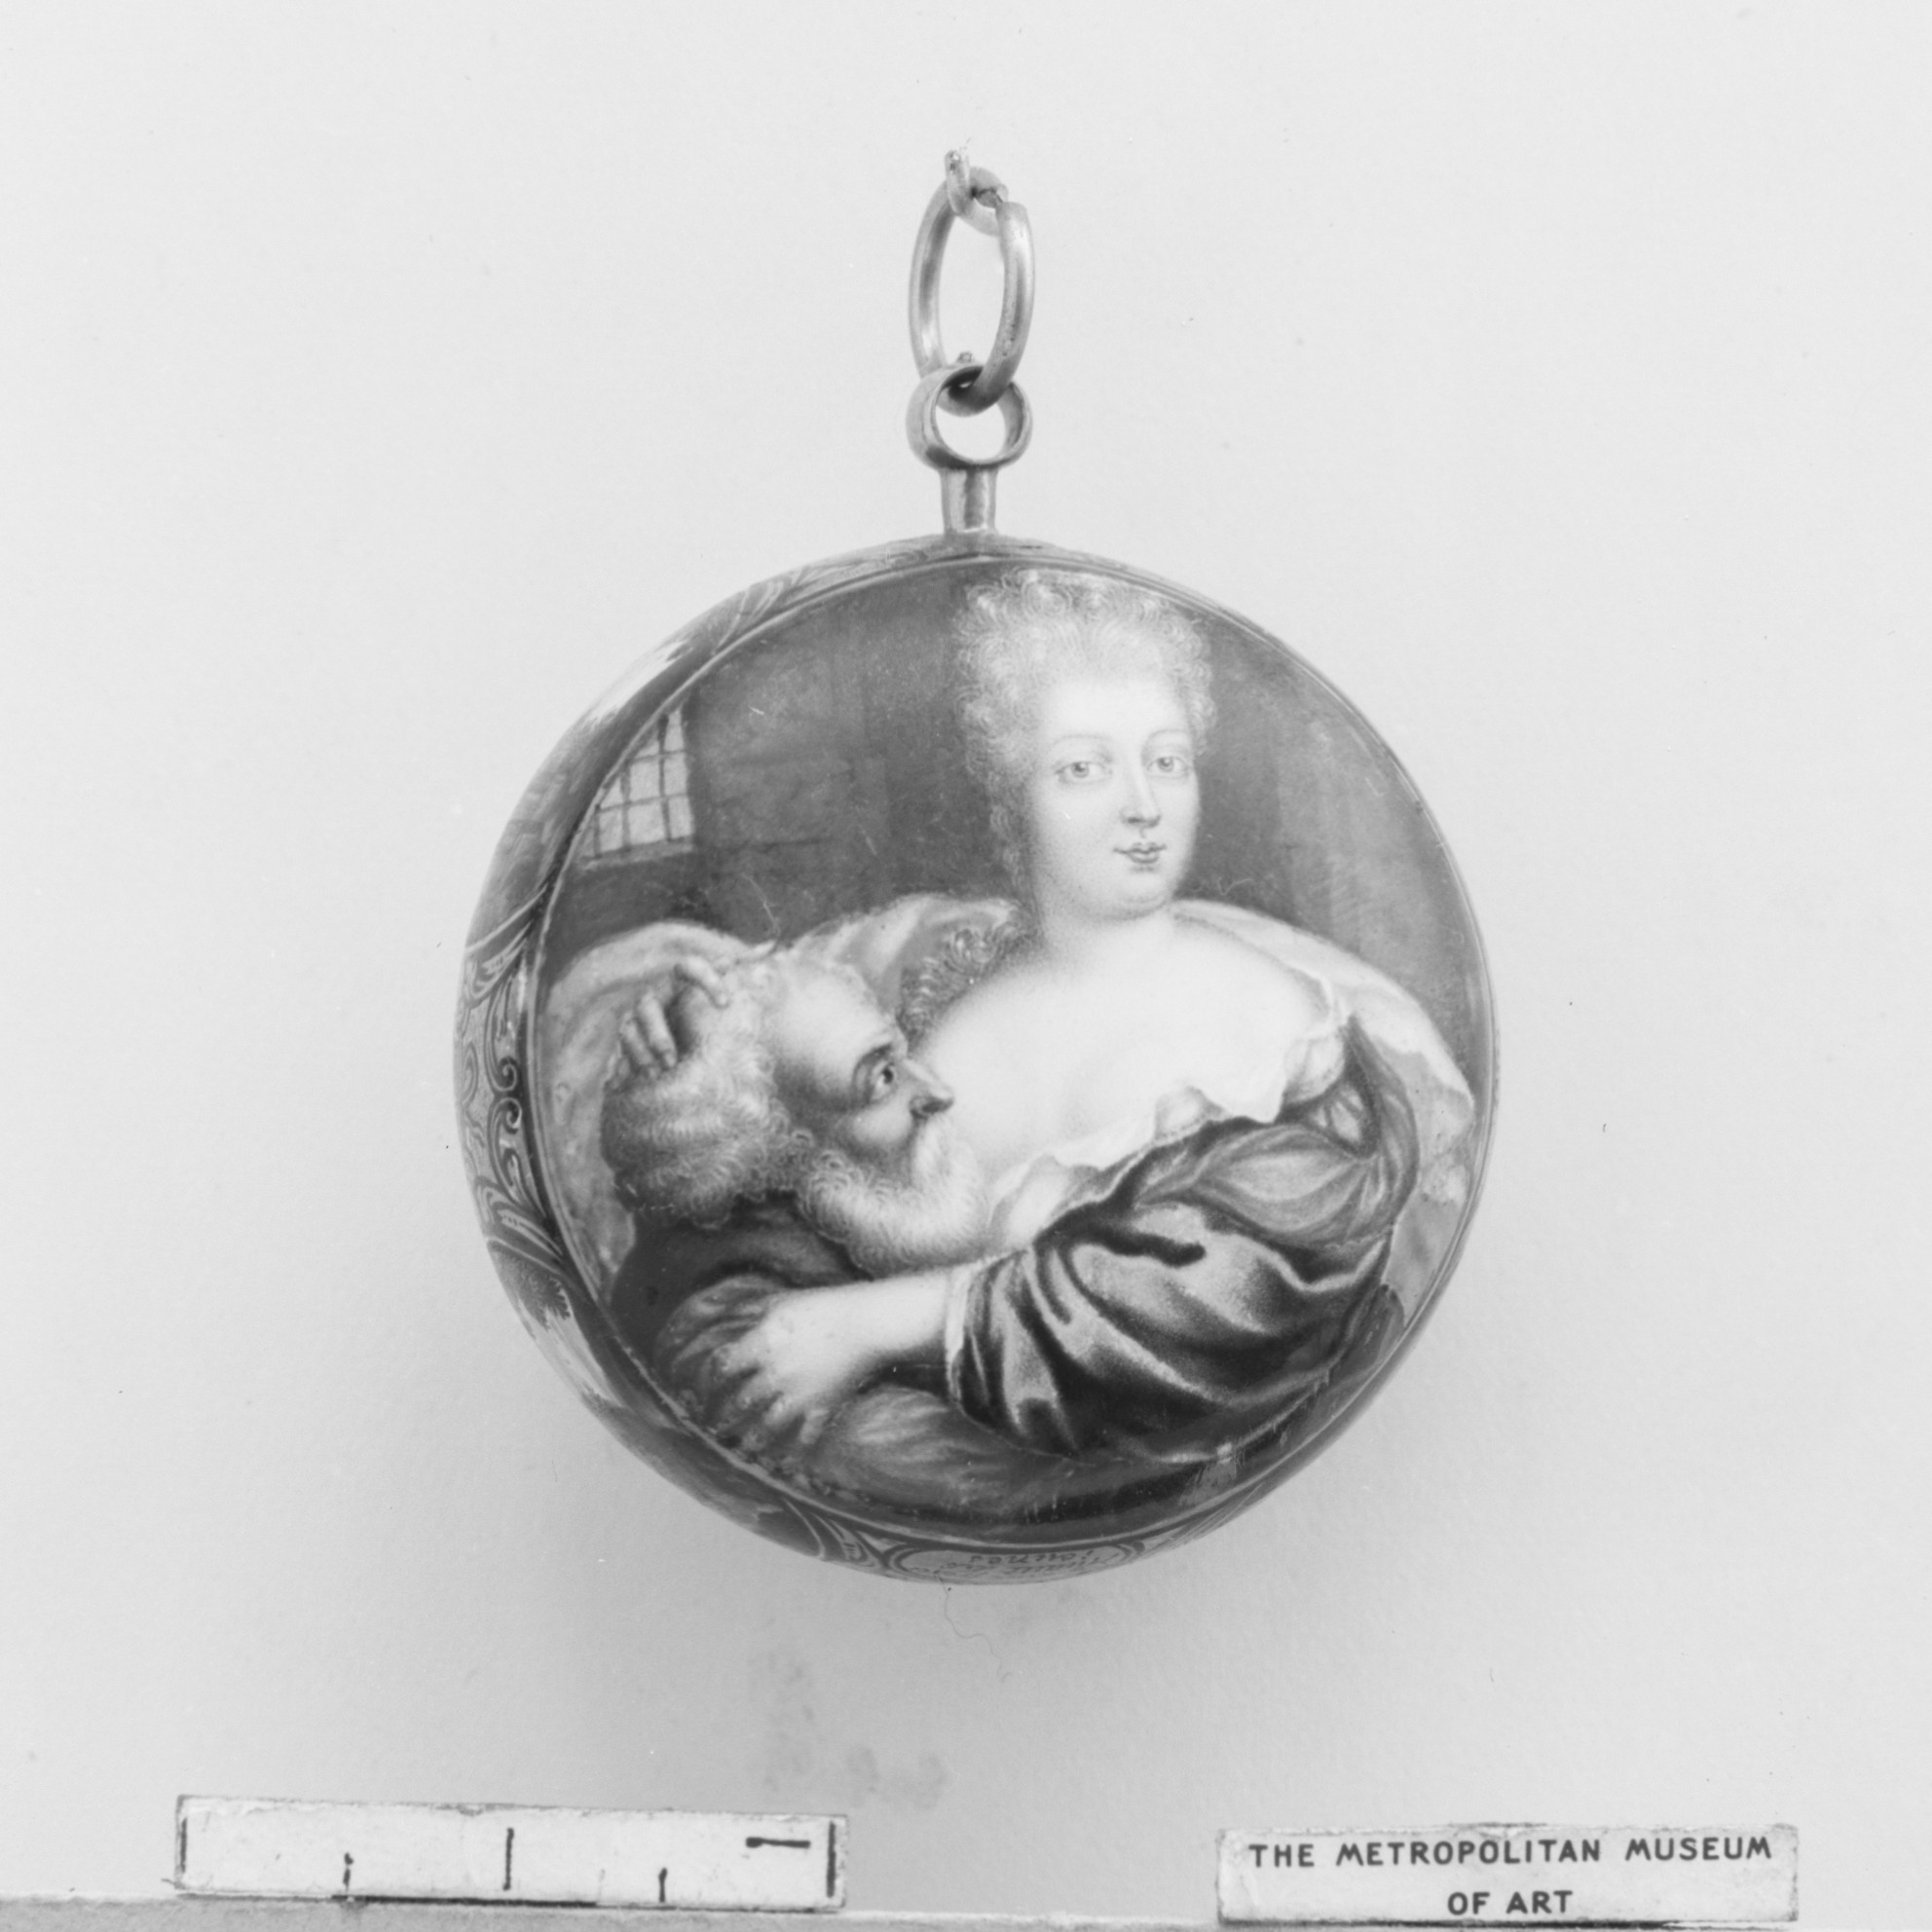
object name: watch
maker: jean romilly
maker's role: maker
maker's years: 1714-1794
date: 1701-1750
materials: enamel, gold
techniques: painting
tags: men,women